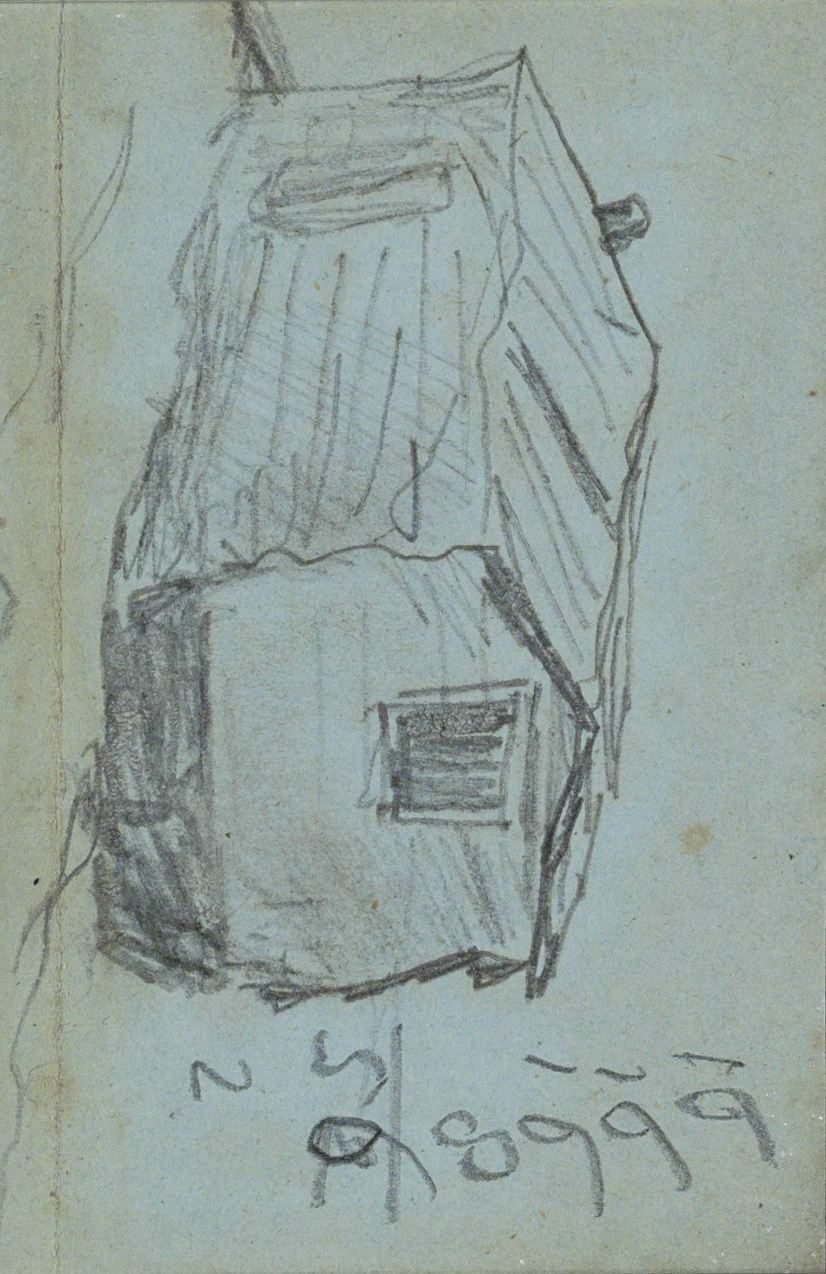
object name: sketchbook leaf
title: Schuur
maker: johan hendrik weissenbruch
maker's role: draughtsman, painter, print maker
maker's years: 1824-1903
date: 1834-1903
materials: paper, pencil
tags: barn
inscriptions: annotation: ‘[...]’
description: Achterste schutblad uit een schetsboek met 32 bladen.